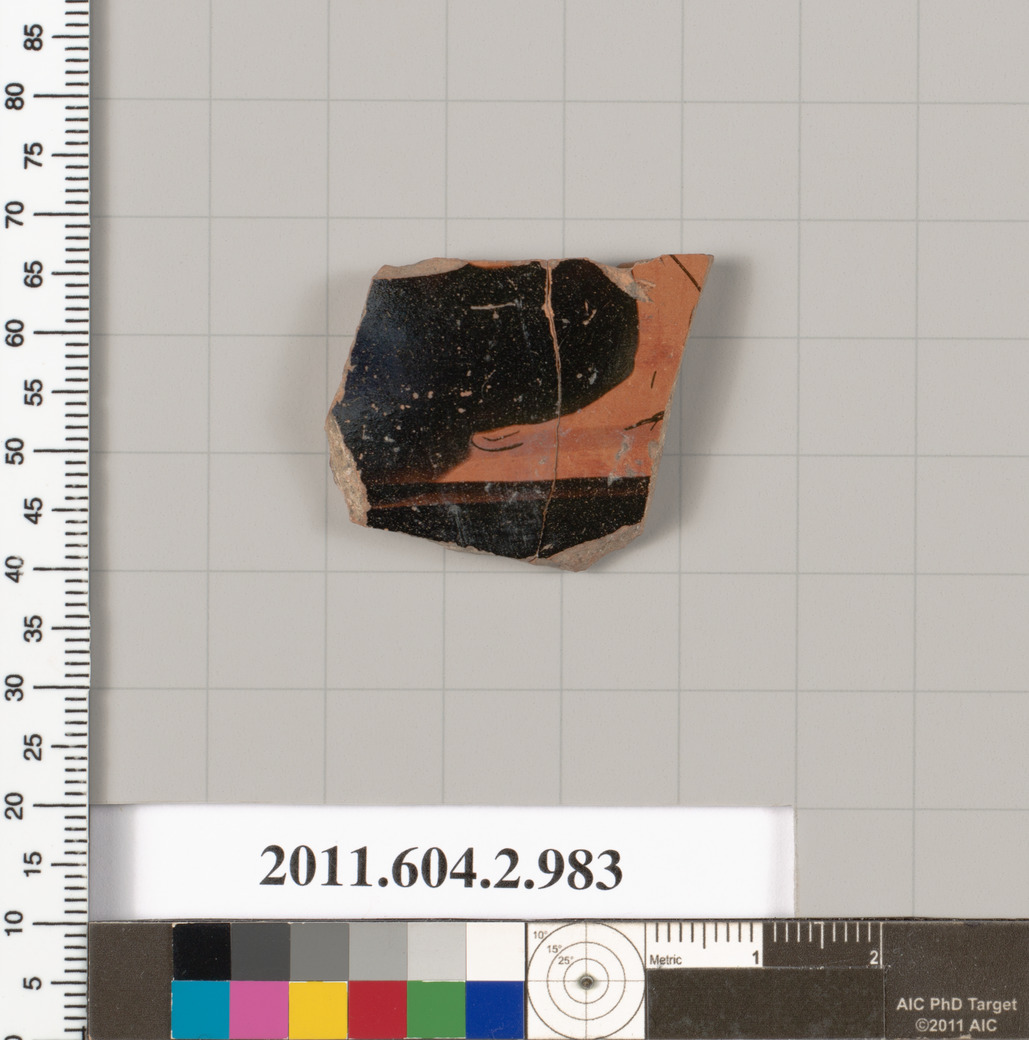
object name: oinochoe fragment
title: Terracotta fragment of an oinochoe (jug)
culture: greek, attic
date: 460-440 BCE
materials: terracotta